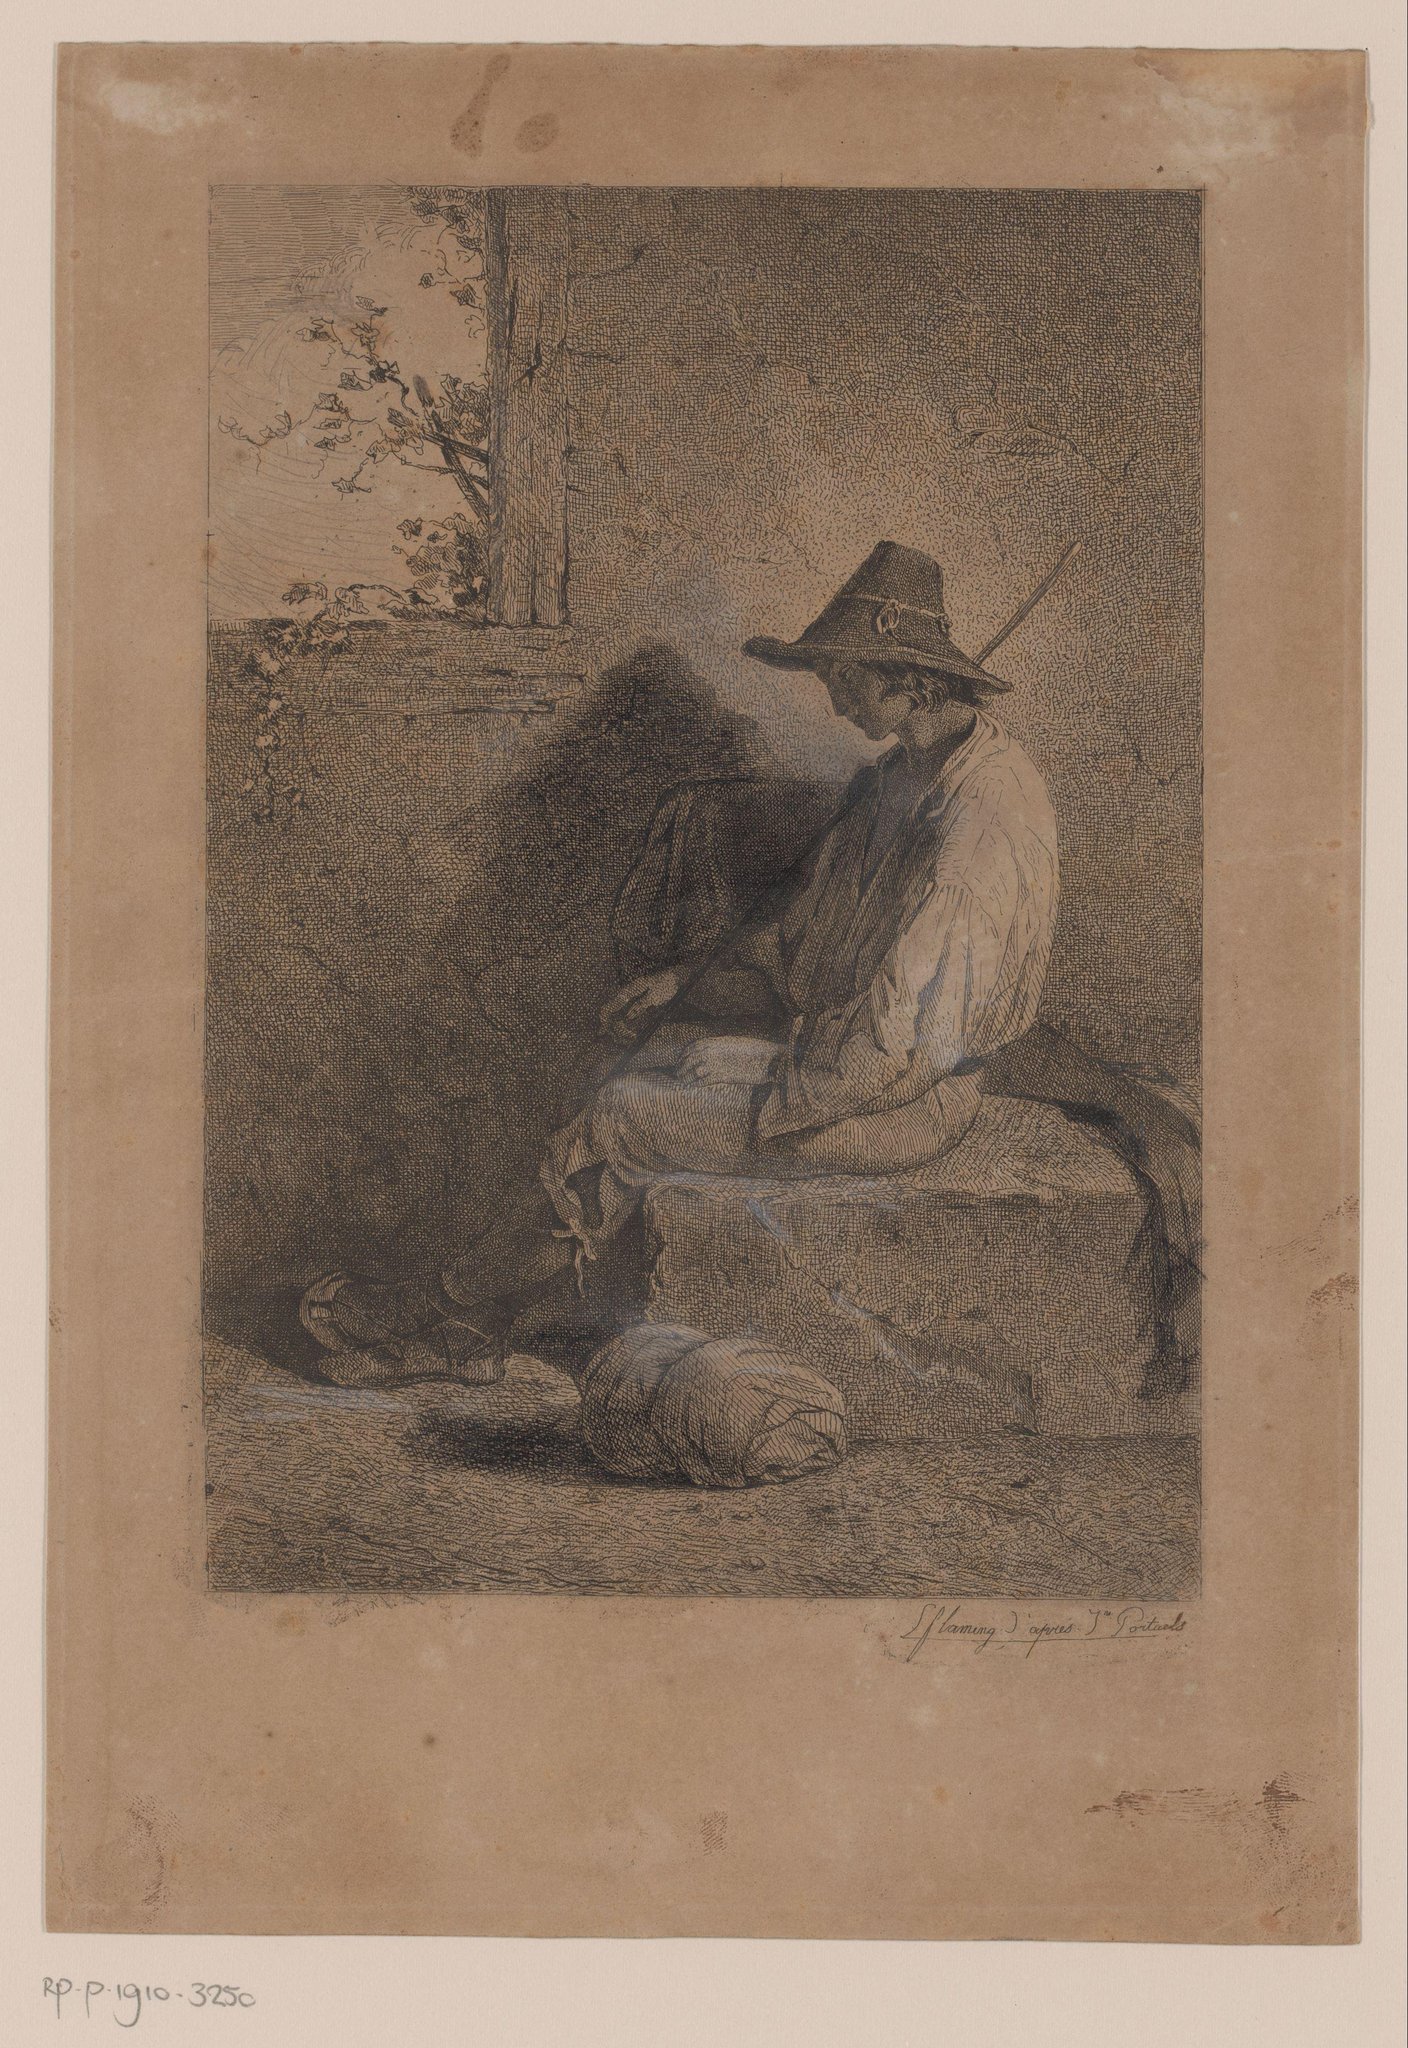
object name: print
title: Rustende herder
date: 1853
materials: paper, pencil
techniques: etching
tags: herding, herdsman, herdswoman, shepherd, shepherdess, cowherd, etc.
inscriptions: collector's mark: Lugt 2228, collector's mark: Lugt 1485